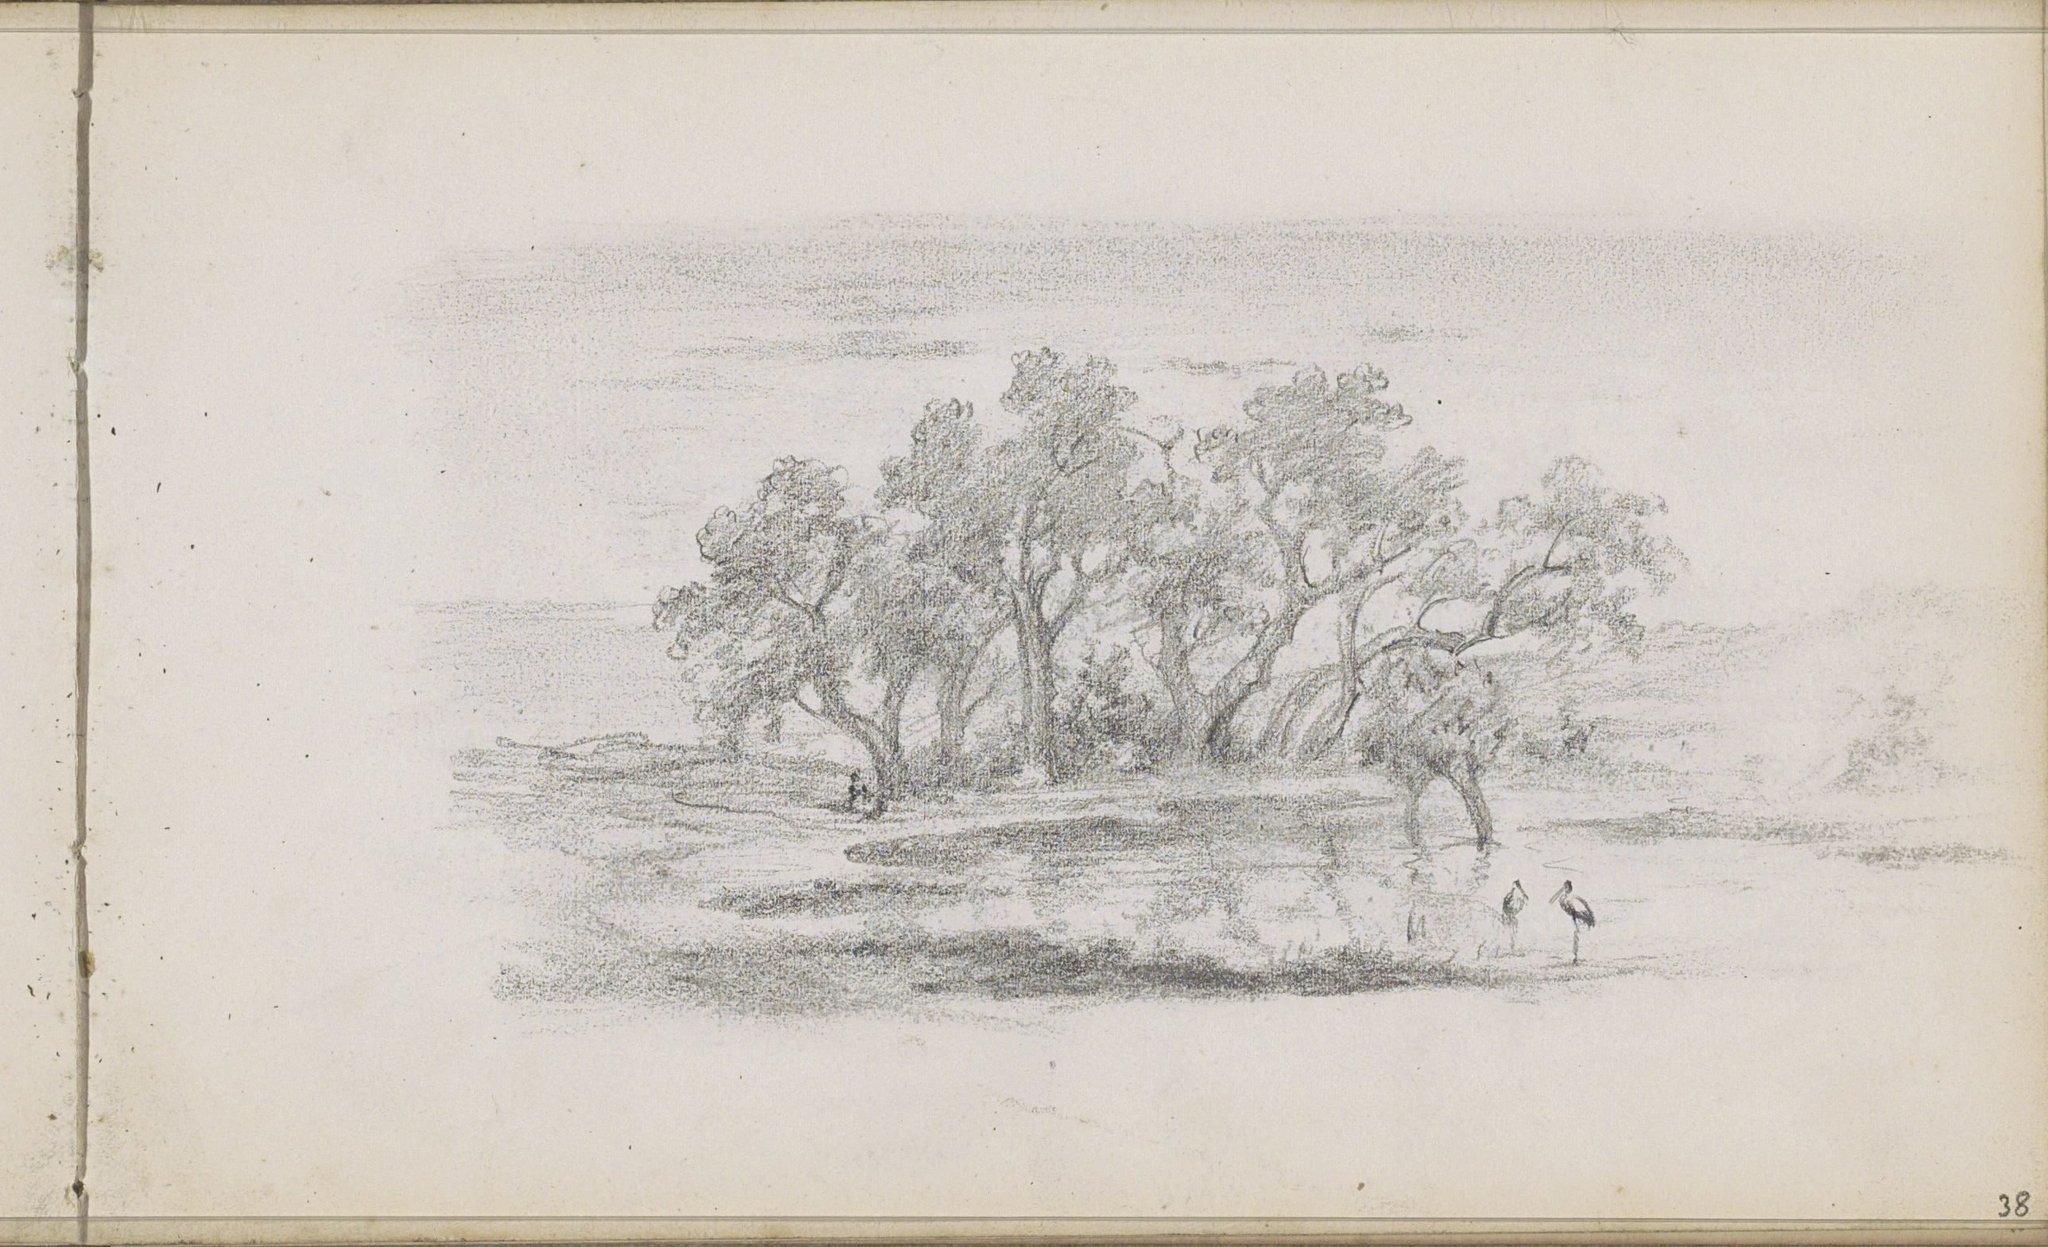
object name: sketchbook leaf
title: Landschap met bomen en reigers bij een plas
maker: willem cornelis rip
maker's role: draughtsman, painter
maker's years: 1856-1922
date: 1874-1875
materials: paper, pencil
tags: trees, shore-birds and wading-birds: heron, pond, pool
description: Blad 38 recto uit een schetsboek met 46 bladen.